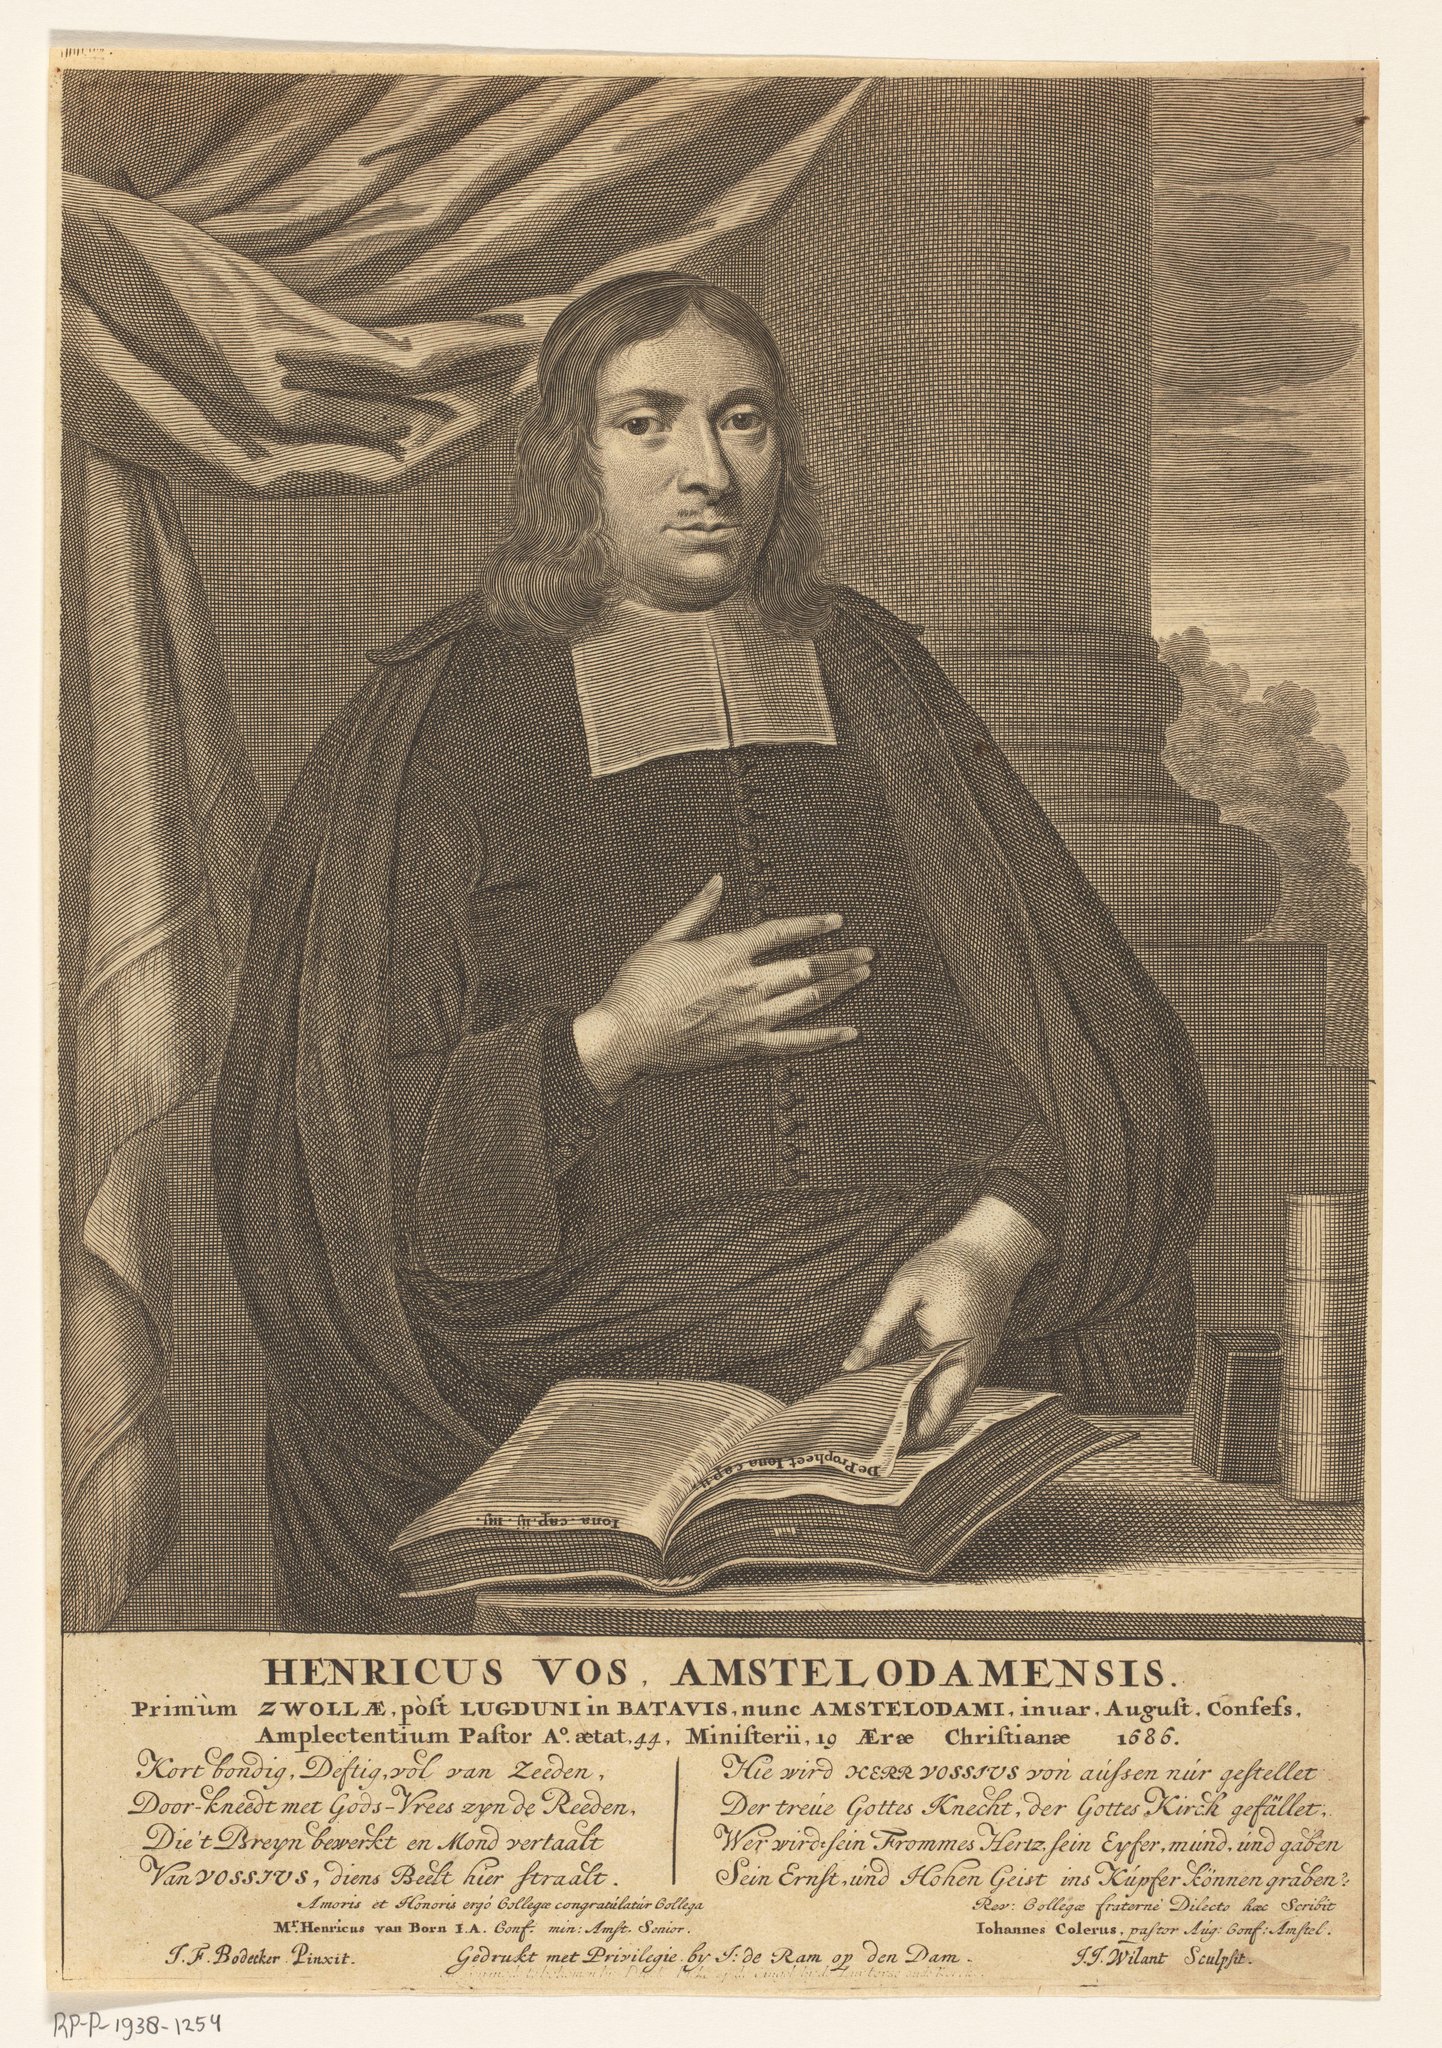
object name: print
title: Portret van de predikant Henricus Vos, op 44-jarige leeftijd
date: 1686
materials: paper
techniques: engraving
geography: amsterdam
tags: amsterdam, henricus vos, the bible as a book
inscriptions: collector's mark: Lugt 2760, collector's mark: Lugt 2228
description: Hij bladert door een Bijbel. In de marge de naam van de geportretteerde, en twee regels met biografische gegevens in het Latijn. Daaronder een vierregelig lofdicht in het Nederlands en in het Duits.